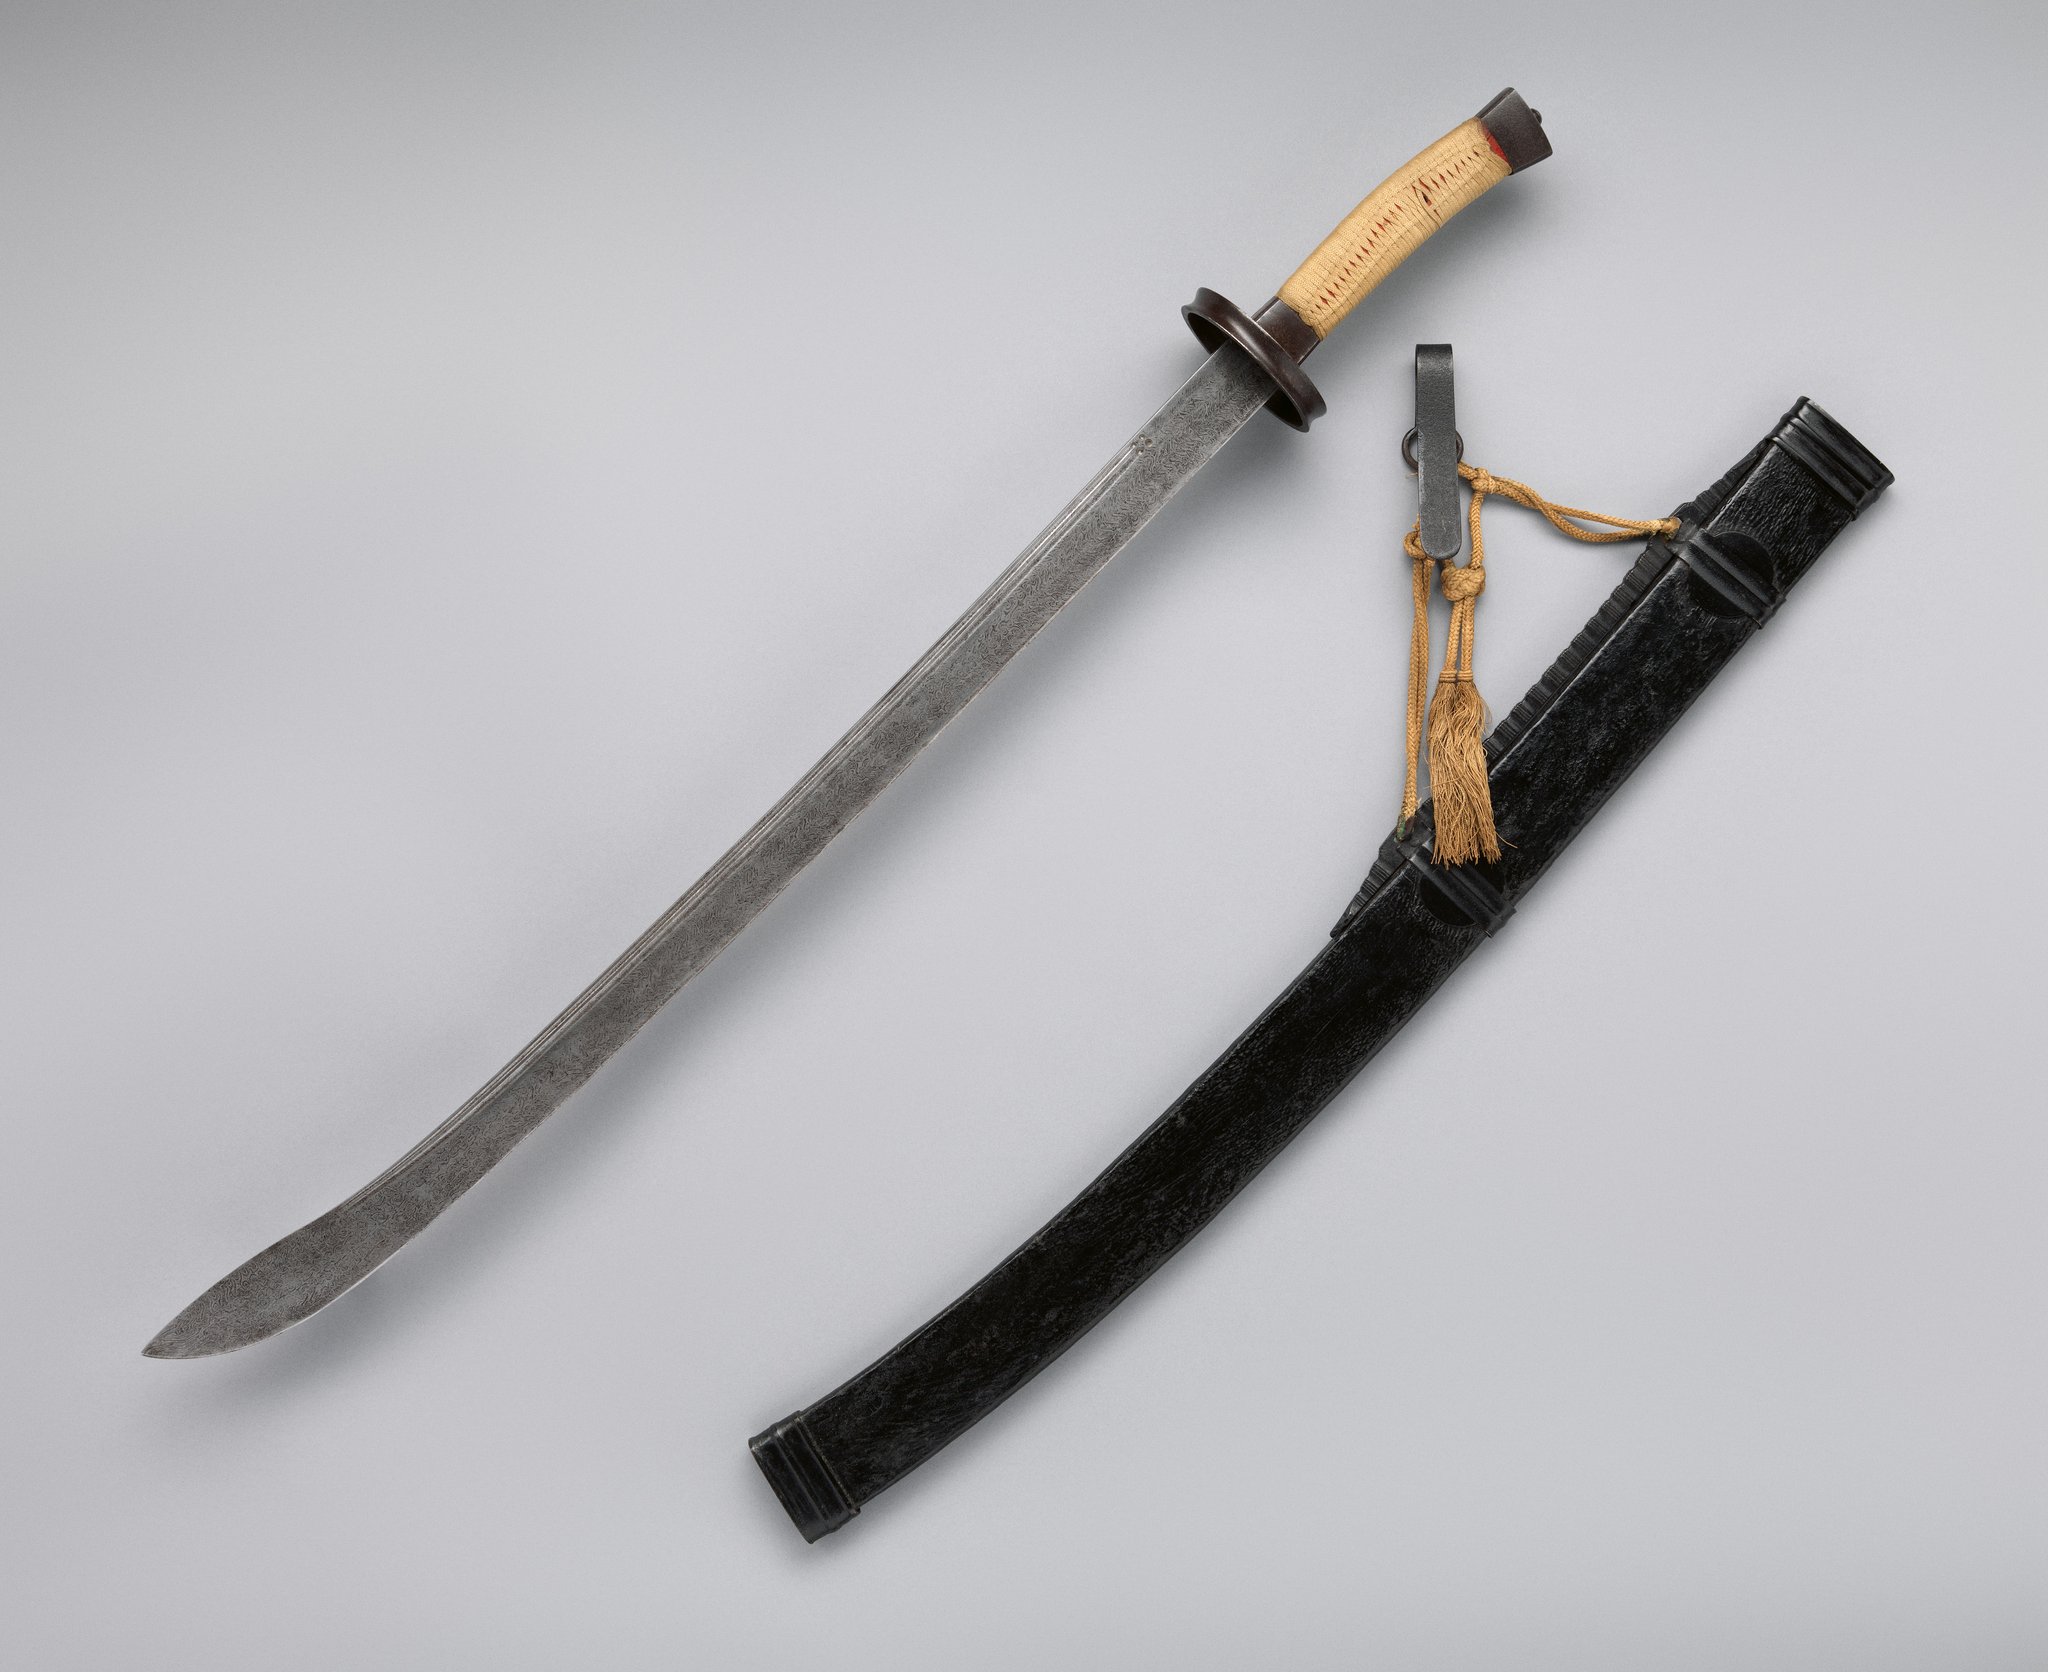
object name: saber with scabbard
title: Saber with Scabbard and Belt Hook (清 腰刀)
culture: chinese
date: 1701-1800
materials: iron, leather, silk, steel, wood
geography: china